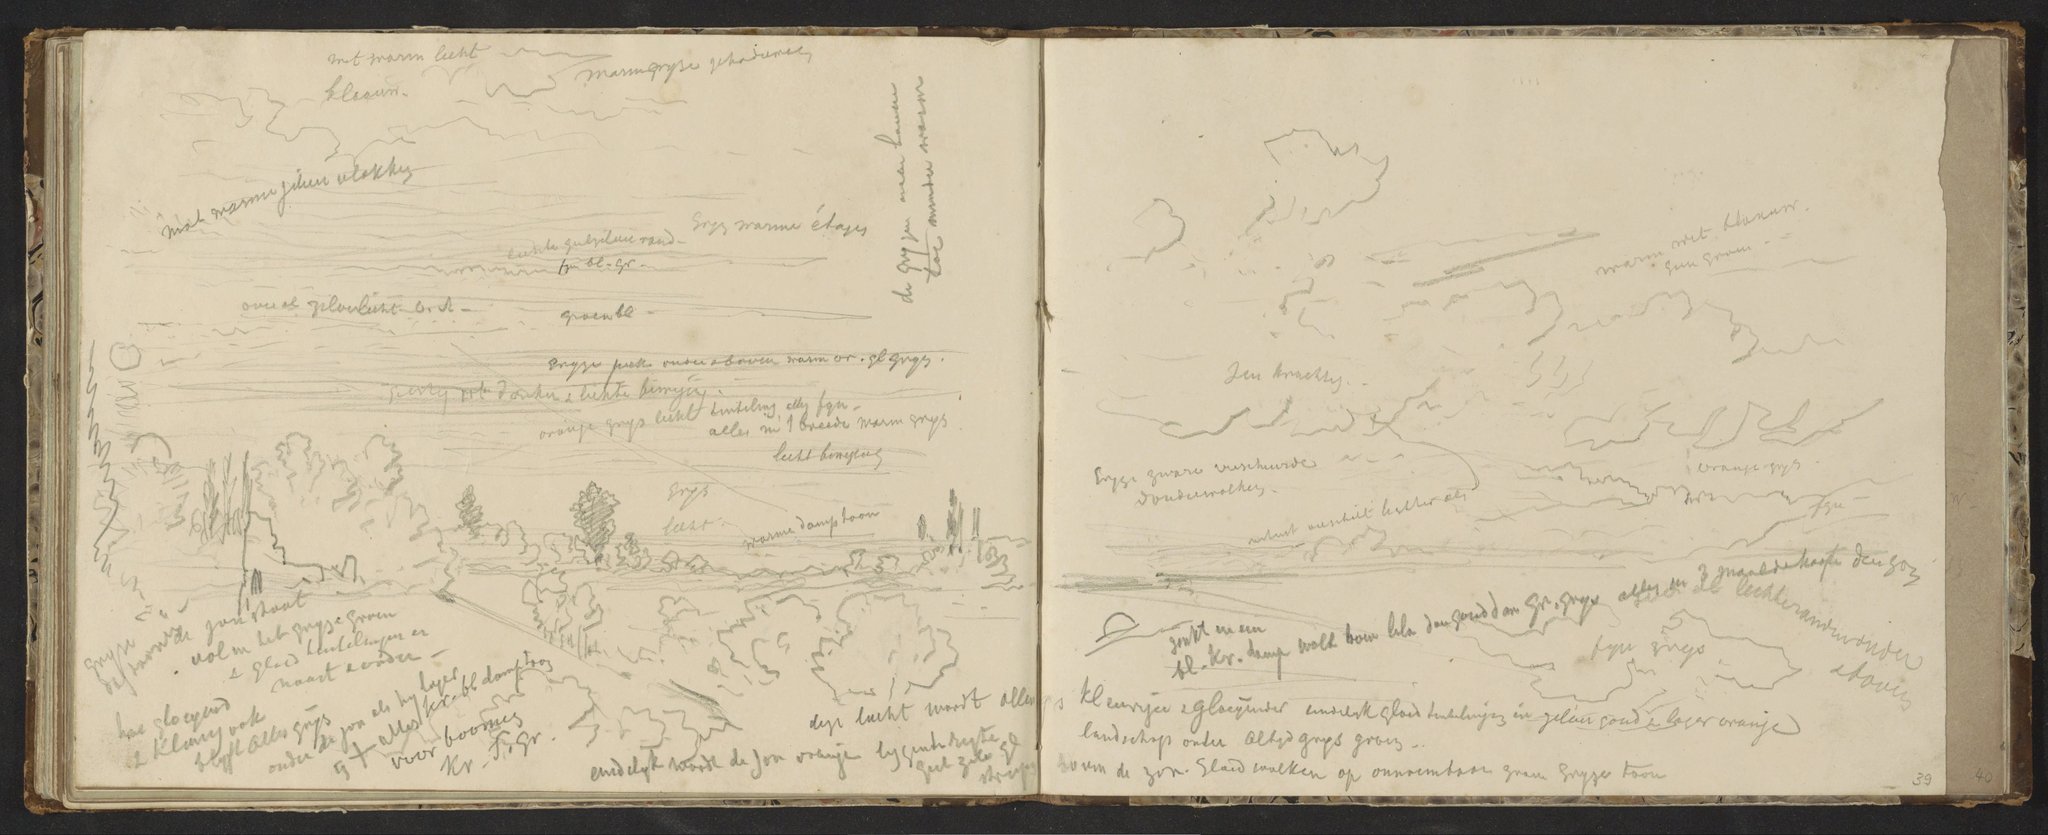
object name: sketchbook leaf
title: Landschap met bomen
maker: johannes tavenraat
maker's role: draughtsman, painter, print maker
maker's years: 1809-1881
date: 1833-1841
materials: paper, pencil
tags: trees, landscapes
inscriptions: kleurnotitie, handgeschreven in potlood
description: Blad 38 verso en 39 recto uit een schetsboek met 41 bladen.